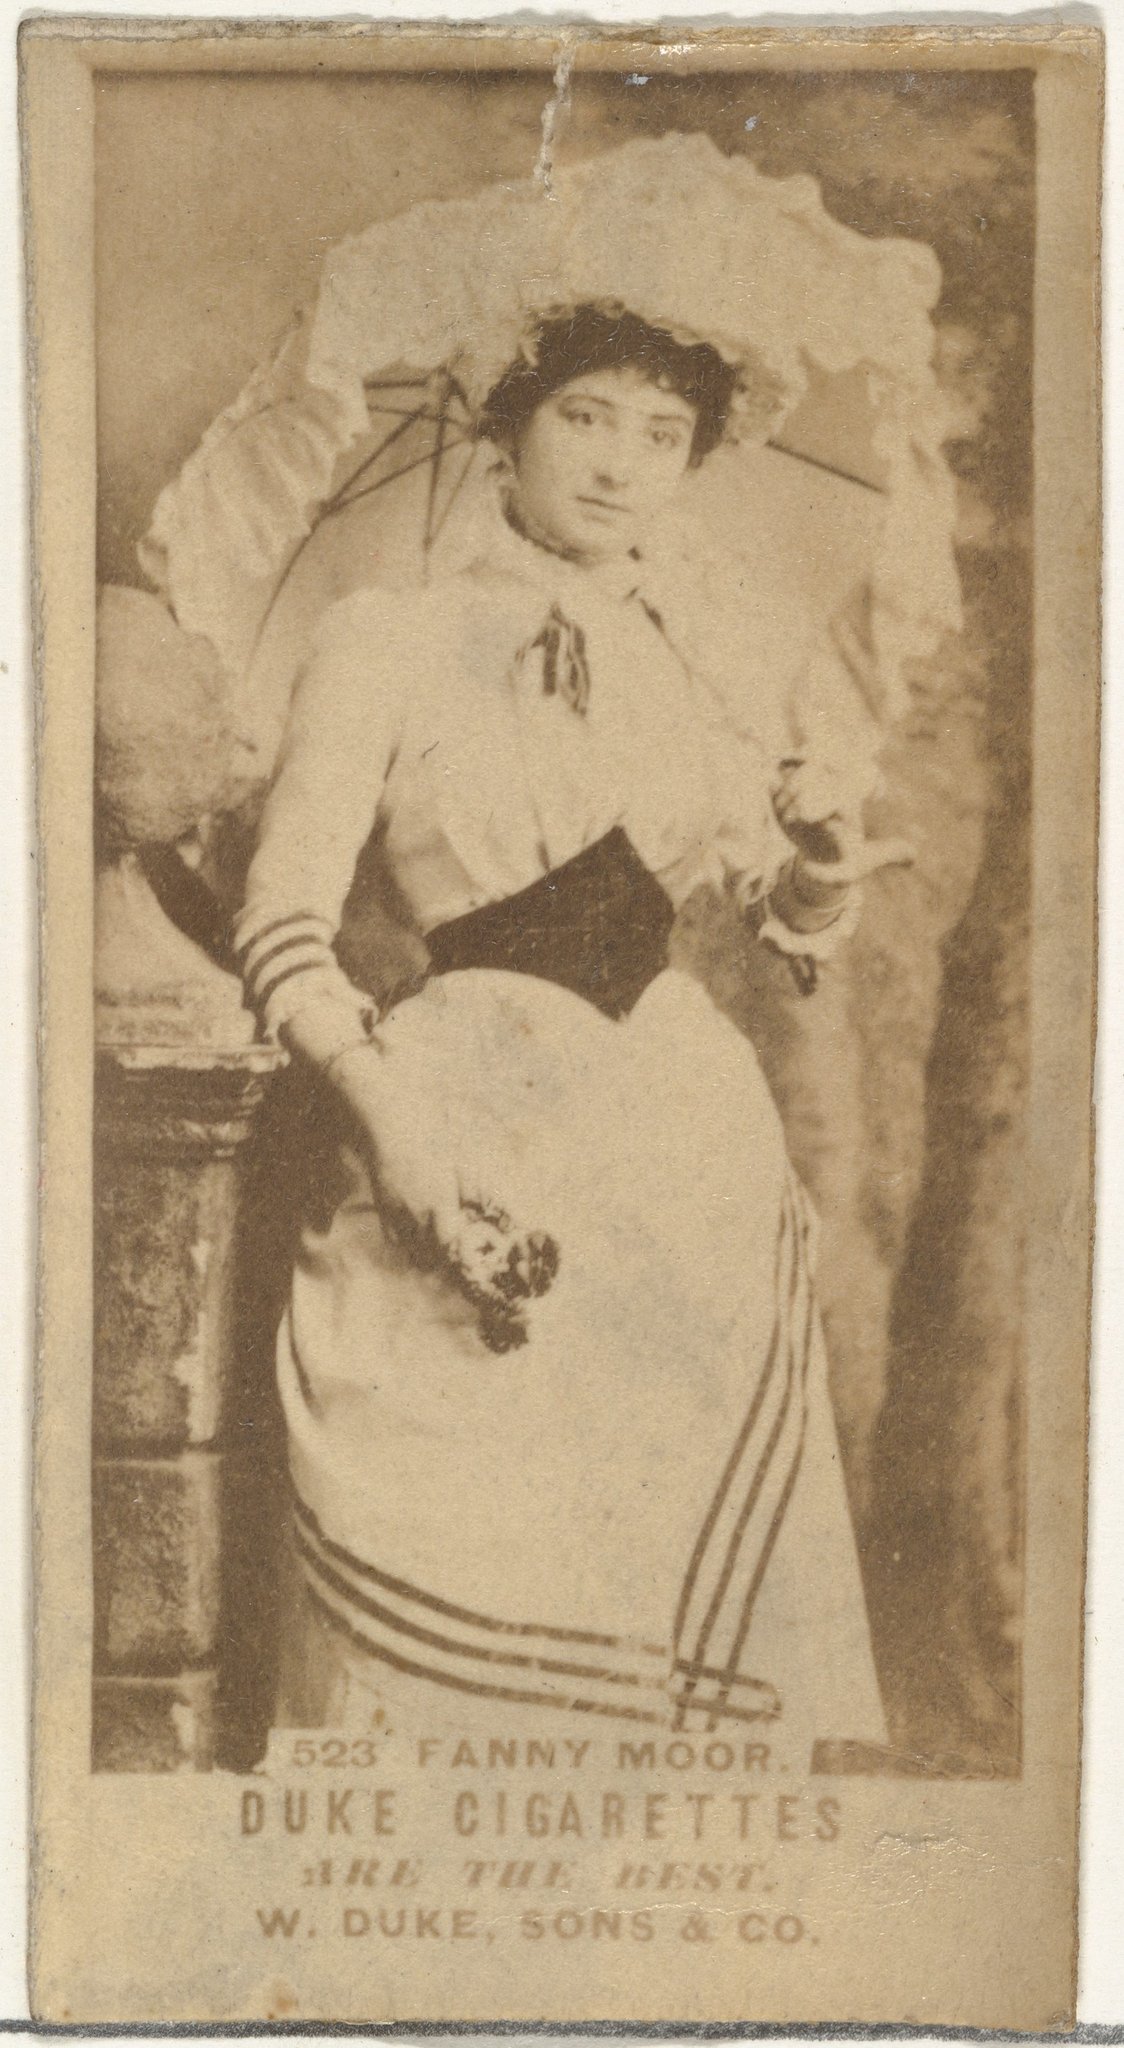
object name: photograph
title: Card Number 523, Fanny Moor, from the Actors and Actresses series (N145-7) issued by Duke Sons & Co. to promote Duke Cigarettes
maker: w. duke, sons & co.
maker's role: publisher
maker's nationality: american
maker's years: 1870-1920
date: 1880-1889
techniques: albumen silver print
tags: portraits,women,actresses